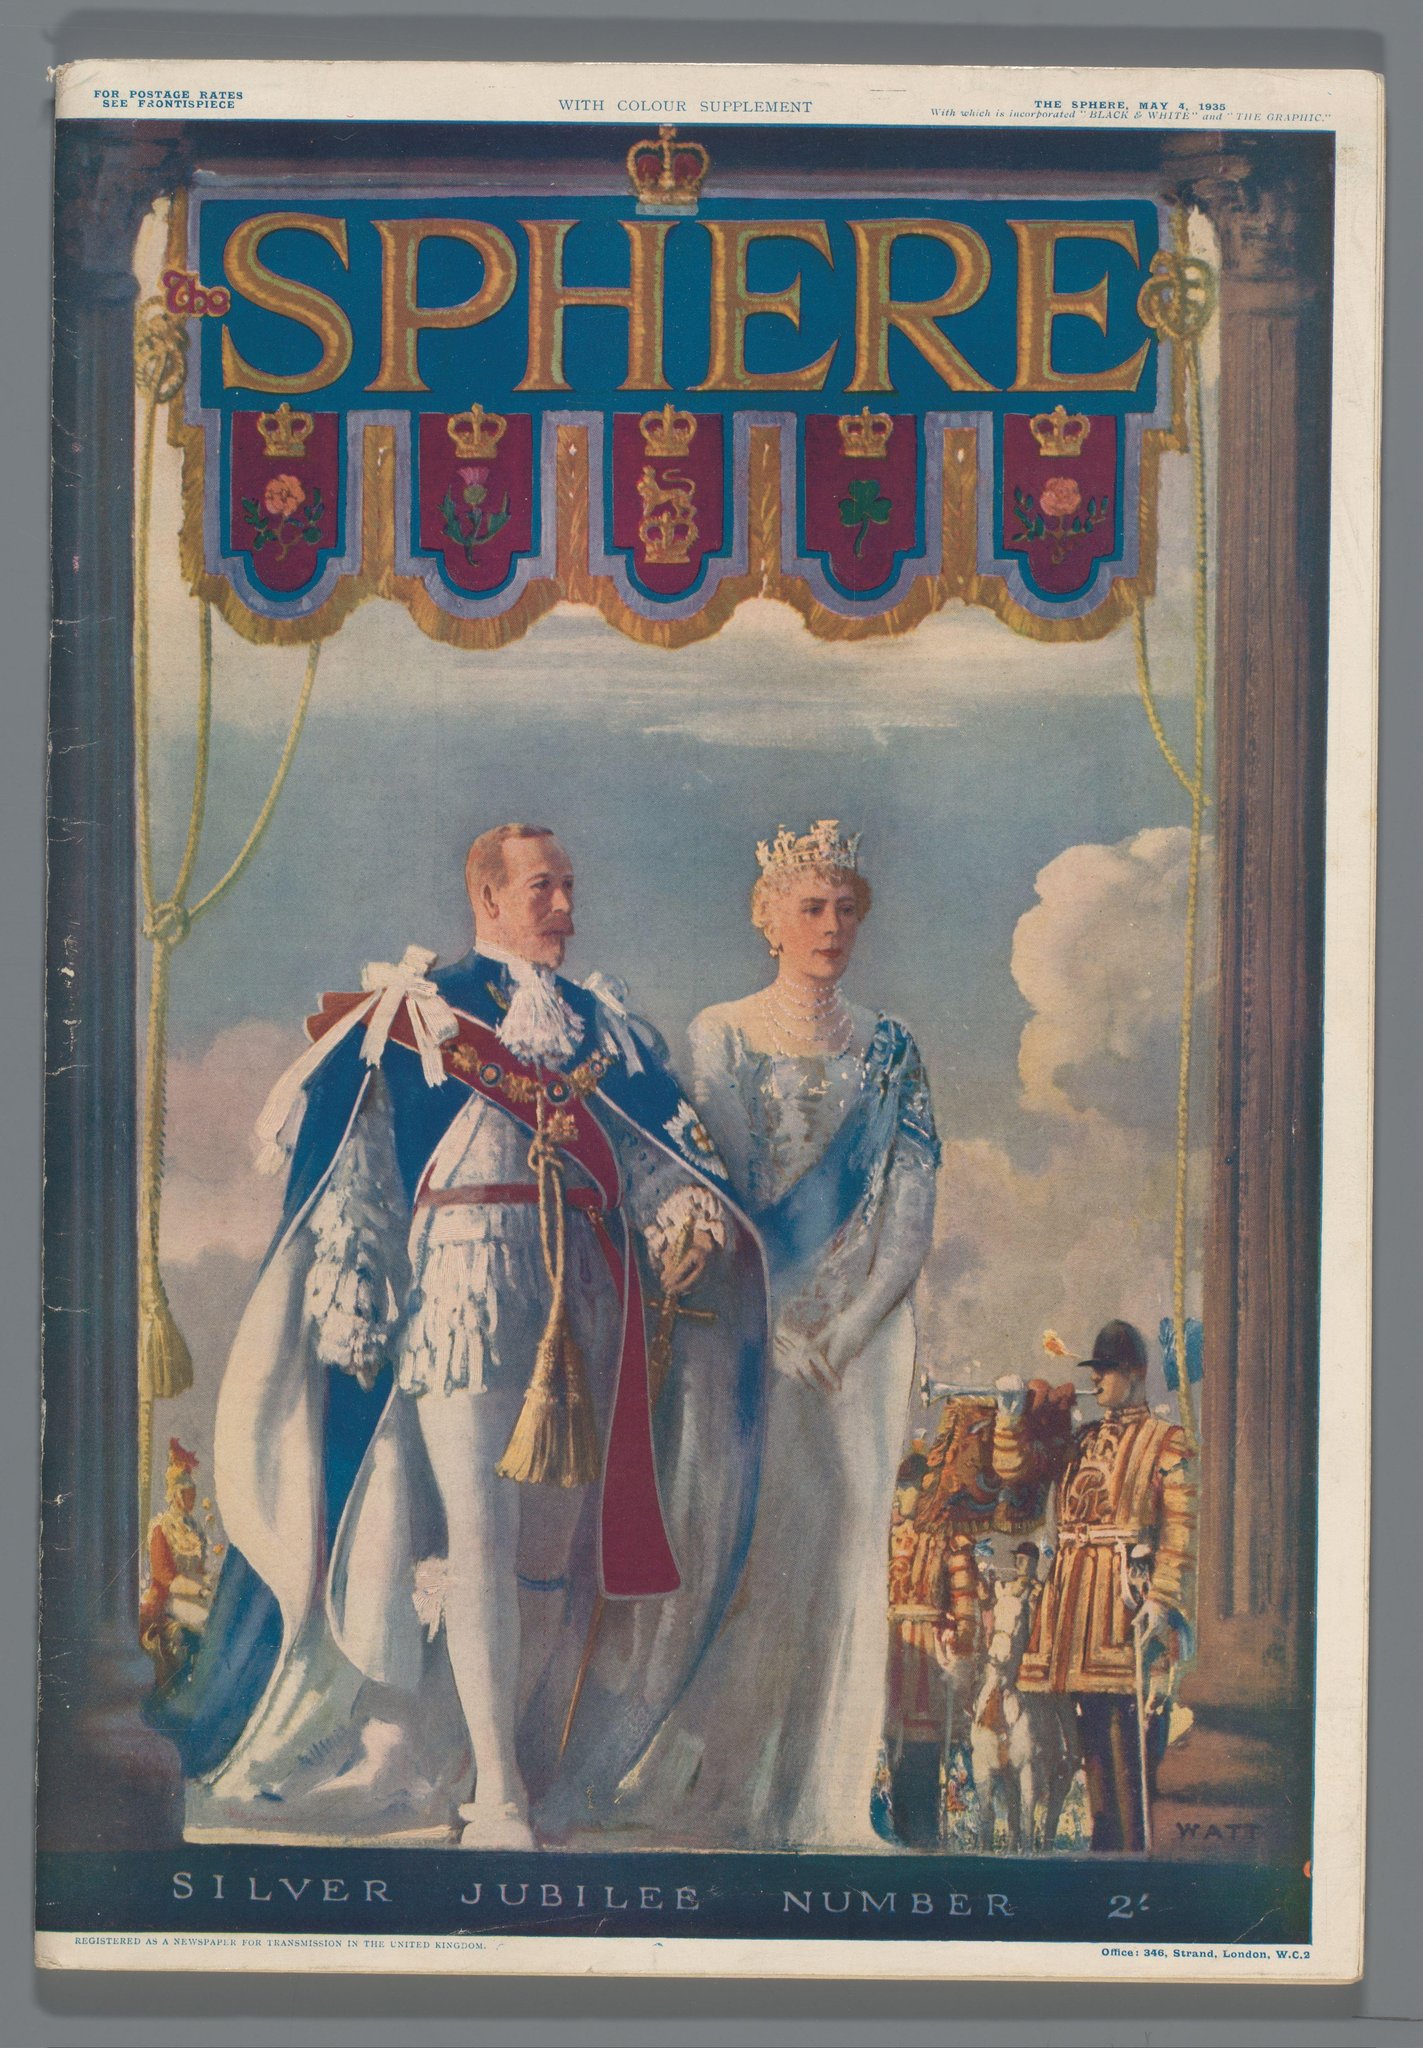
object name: print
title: Exemplaar van het tijdschrift 'The Sphere' van 4 mei 1935 over het zilveren jubileum van koning George V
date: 1935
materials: paper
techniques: printed materials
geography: london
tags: london, public festivities on the occasion of royal events, commemoration, jubilee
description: Exemplaar van het tijdschrift 'The Sphere', no. 1841 van 4 mei 1935 over het zilveren jubileum van het koningschap van de Britse koning George V op 6 mei 1910.